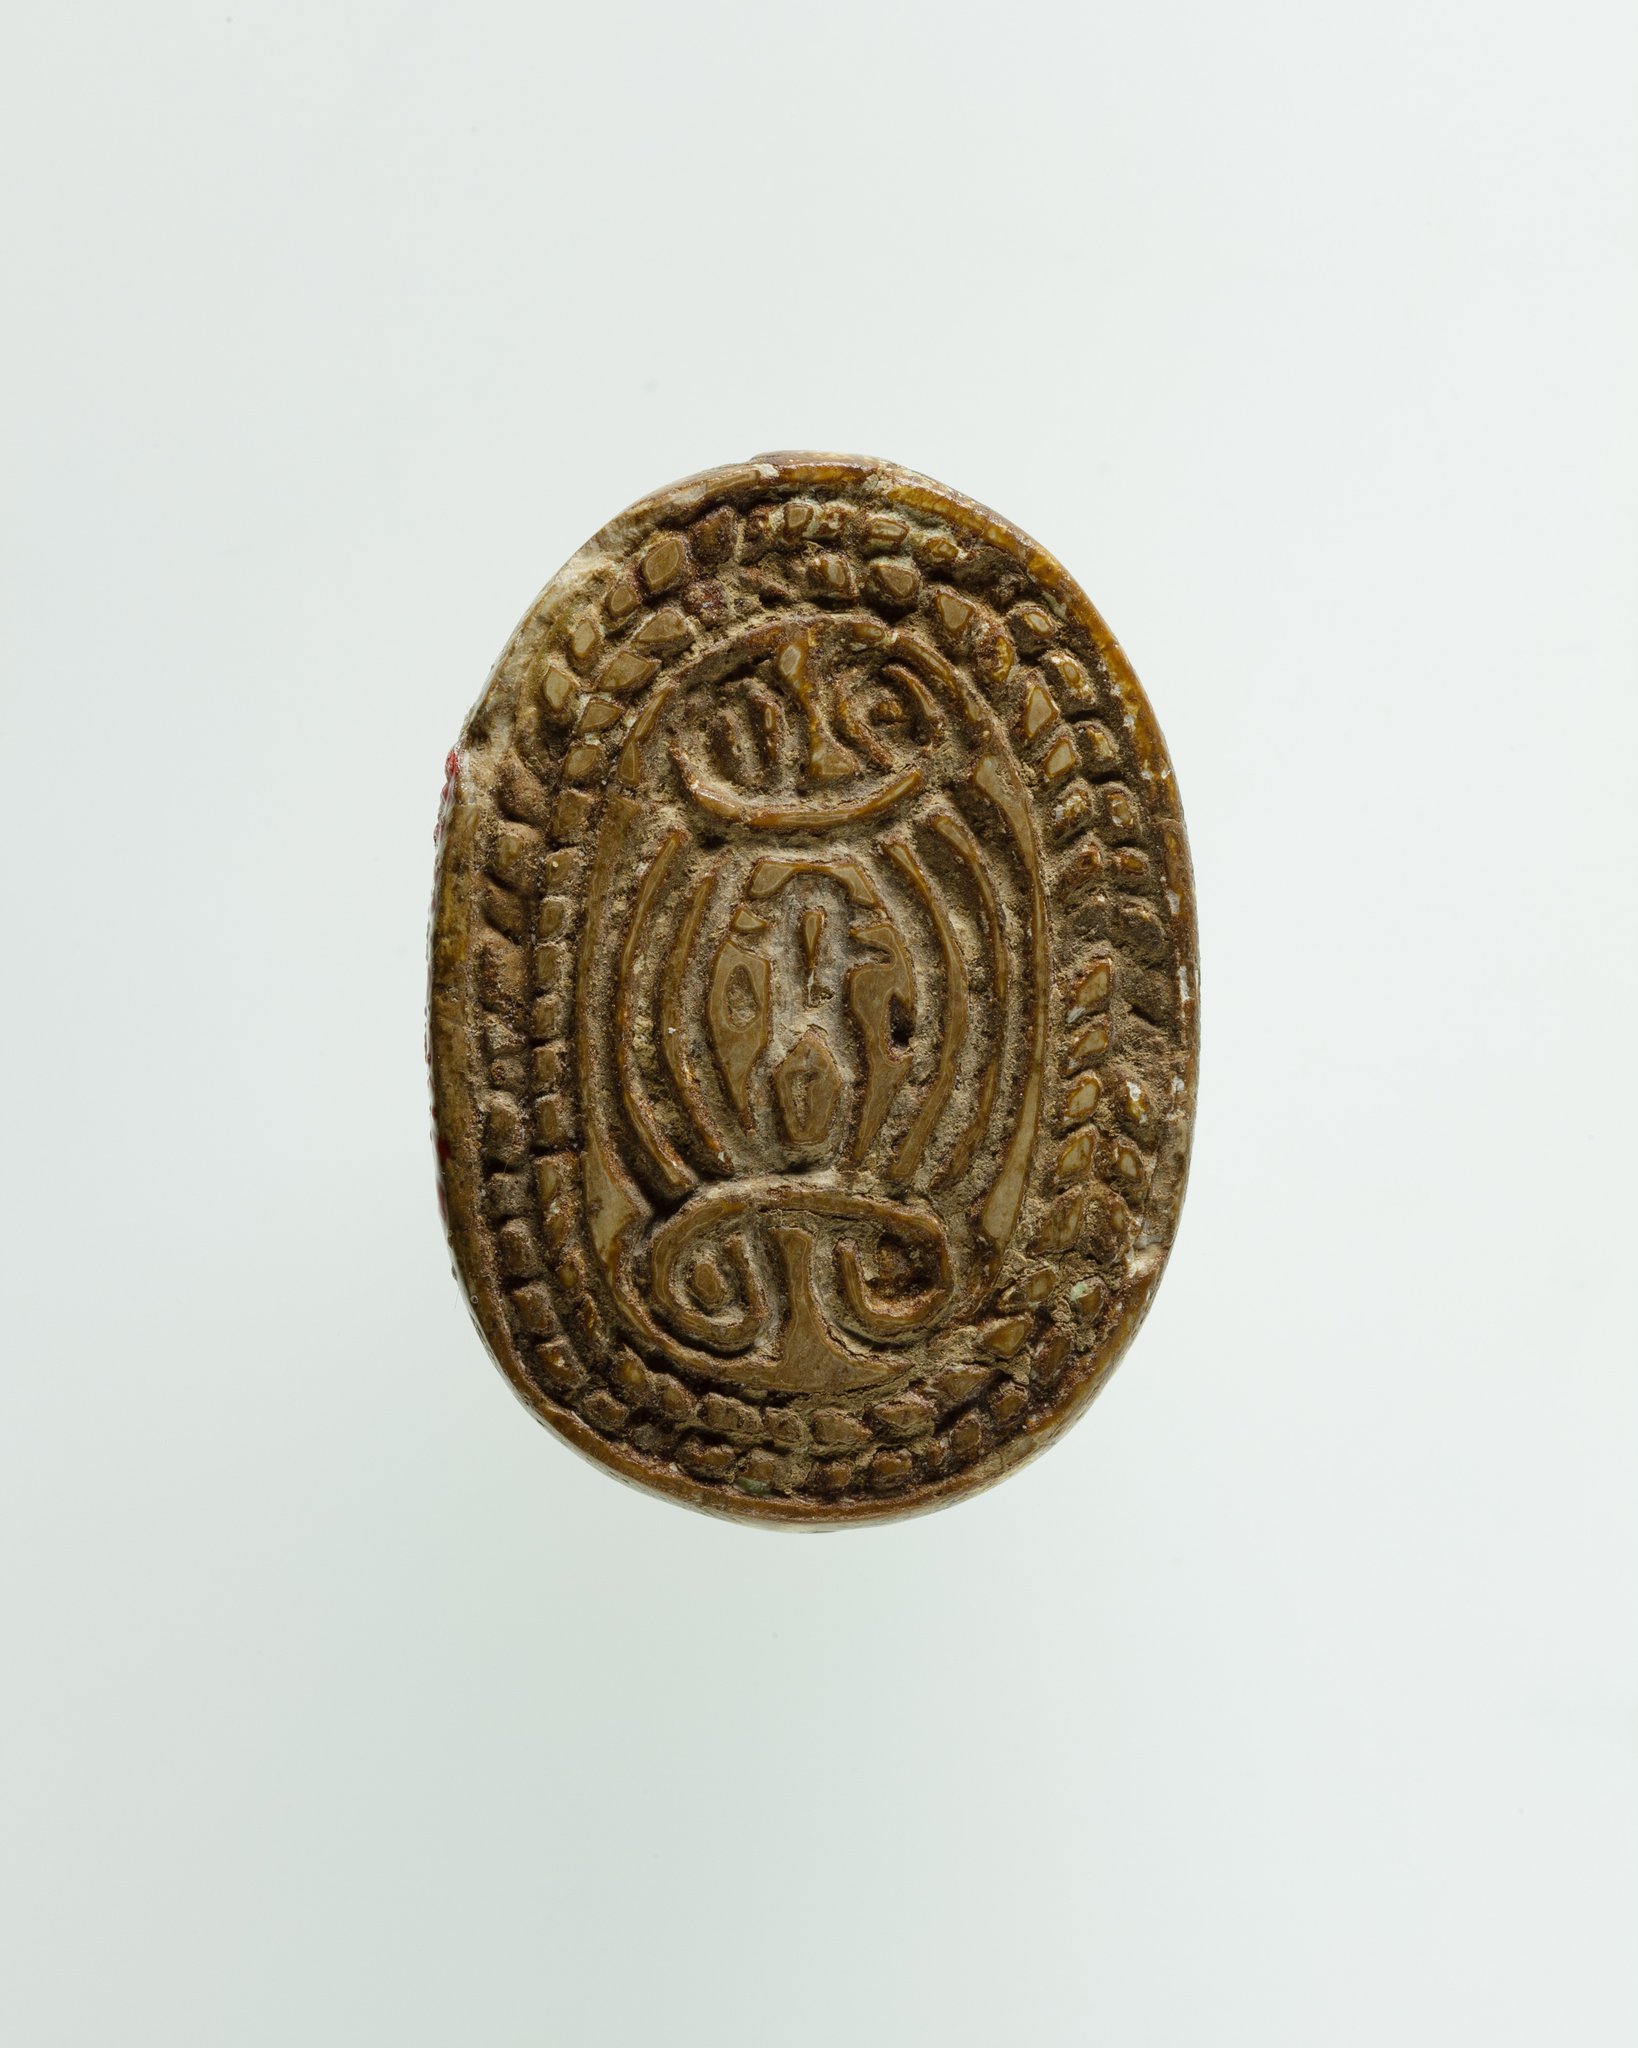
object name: scarab, convoluted coil, rope border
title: Scarab Incised with Nefer Sign and Coil Design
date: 1850-1802 BCE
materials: glaze, stone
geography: egypt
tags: scarabs